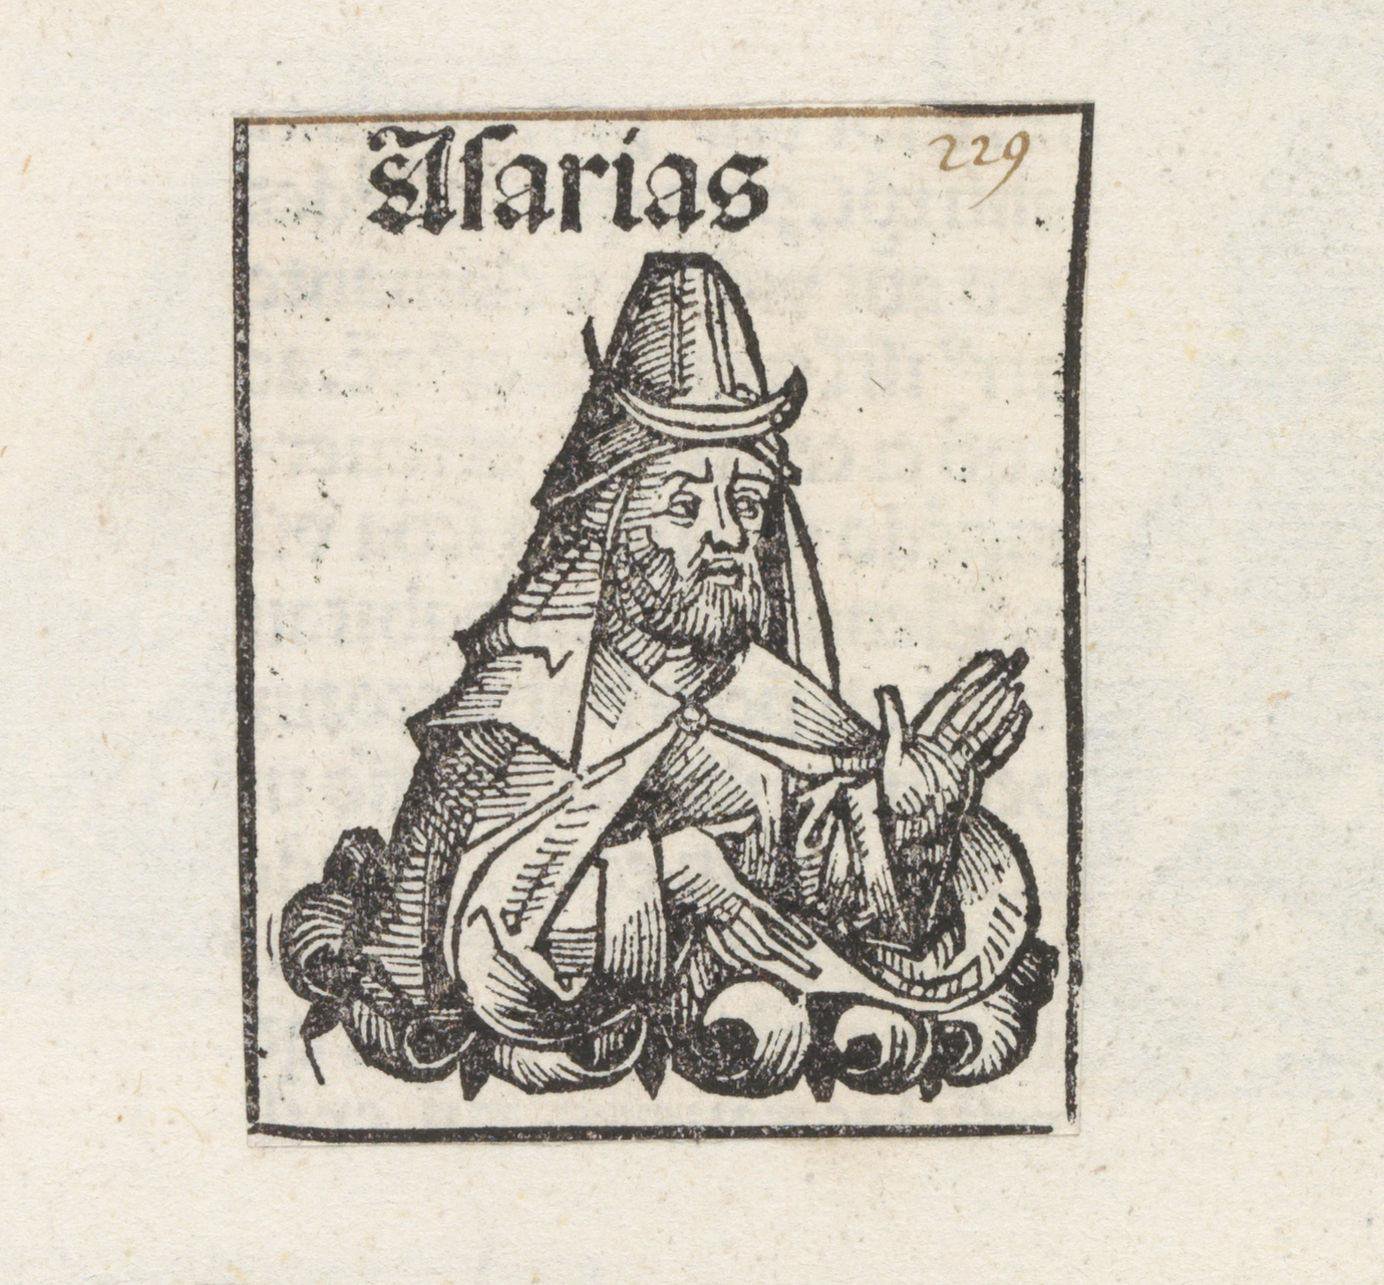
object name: print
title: Asarias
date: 1493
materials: paper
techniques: letterpress printing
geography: nuremberg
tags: high priest ~ hierarchy of priests, persons from the old testament (not in biblical context, nor occurring in legendary/historical extensions included in division 71)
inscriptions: inscription: ‘229’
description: Een bloemkelk met een man in priesterkledij, naar rechts gekeerd. De tekst identificeert hem als Azarja II, hogepriester. De voorstelling is onderdeel van de opeenvolging priesters in de Liber Chronicarum. De prent maakt deel uit van een album.